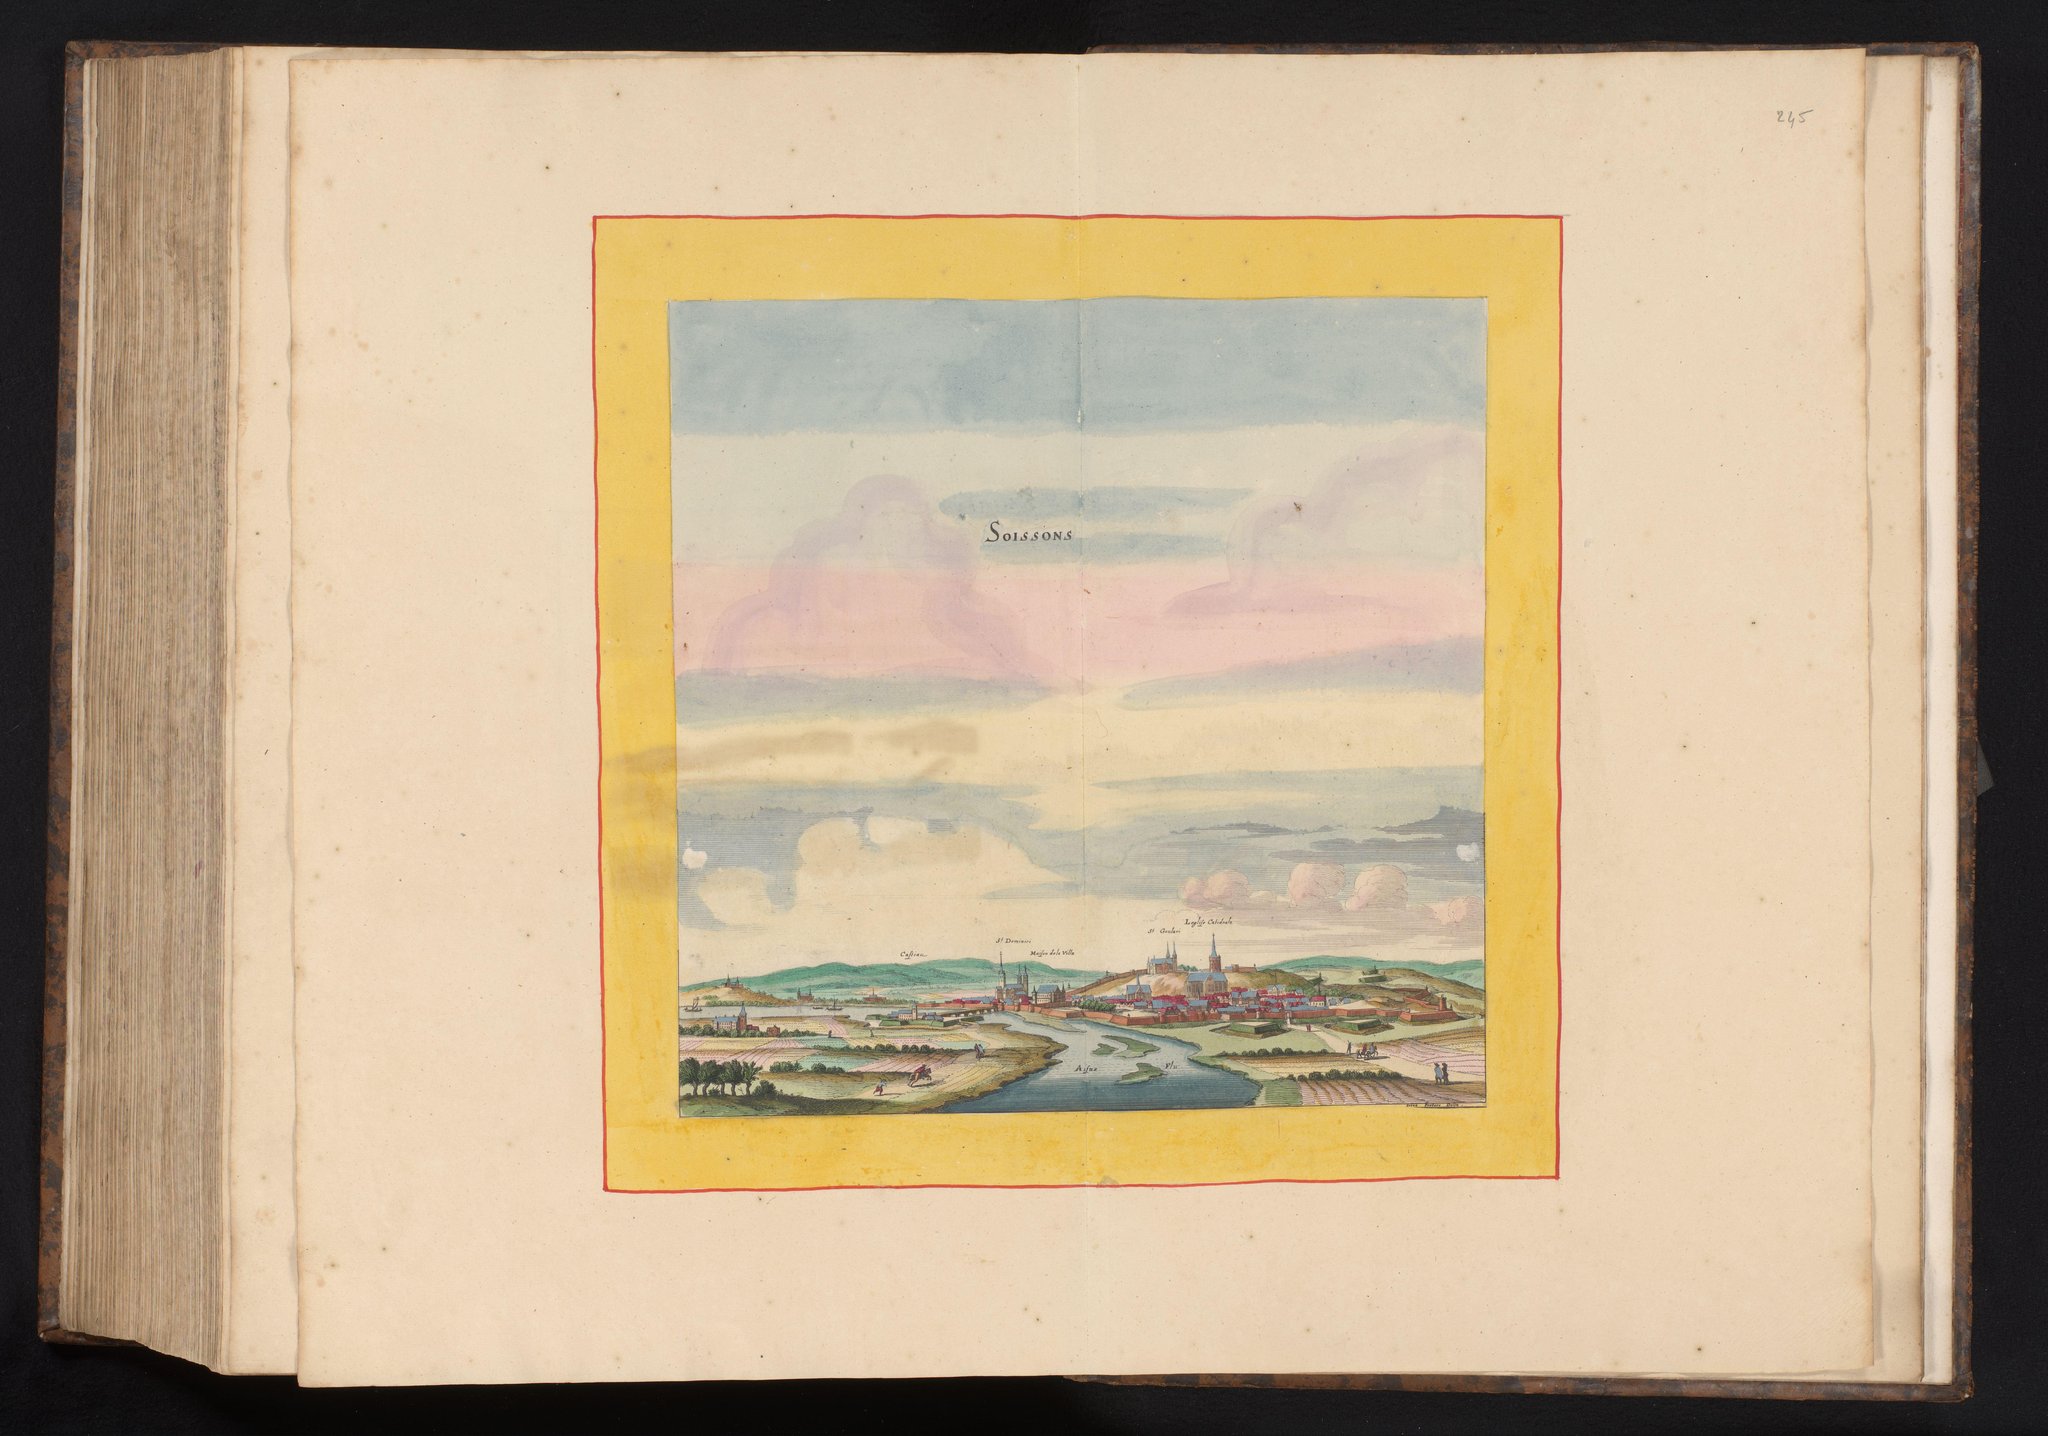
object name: album leaf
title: Gezicht op de stad Soissons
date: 1655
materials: paper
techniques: engraving, etching, hand coloring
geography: the hague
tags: city-view in general; 'veduta', river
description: Prent origineel vervaardigd als boekillustratie voor: Zeiller, Martin. Topographia Galliae, oder Beschreibung und Contrafaitung der vornehmbsten und bekantisten Oerter in dem mächtigen und grossen Königreich Frankreich, 13 delen. Frankfurt am Main: Caspar Merian, 1655-1661. De prent werd voor het eerst gepubliceerd in deel 1: Topographia Galliae, 1655. De prent is langs de bovenrand van de voorstelling afgescheurd. De titel is hoger opgeplakt. De voorstelling is aan de bovenzijde aangevuld met een geschilderde lucht.